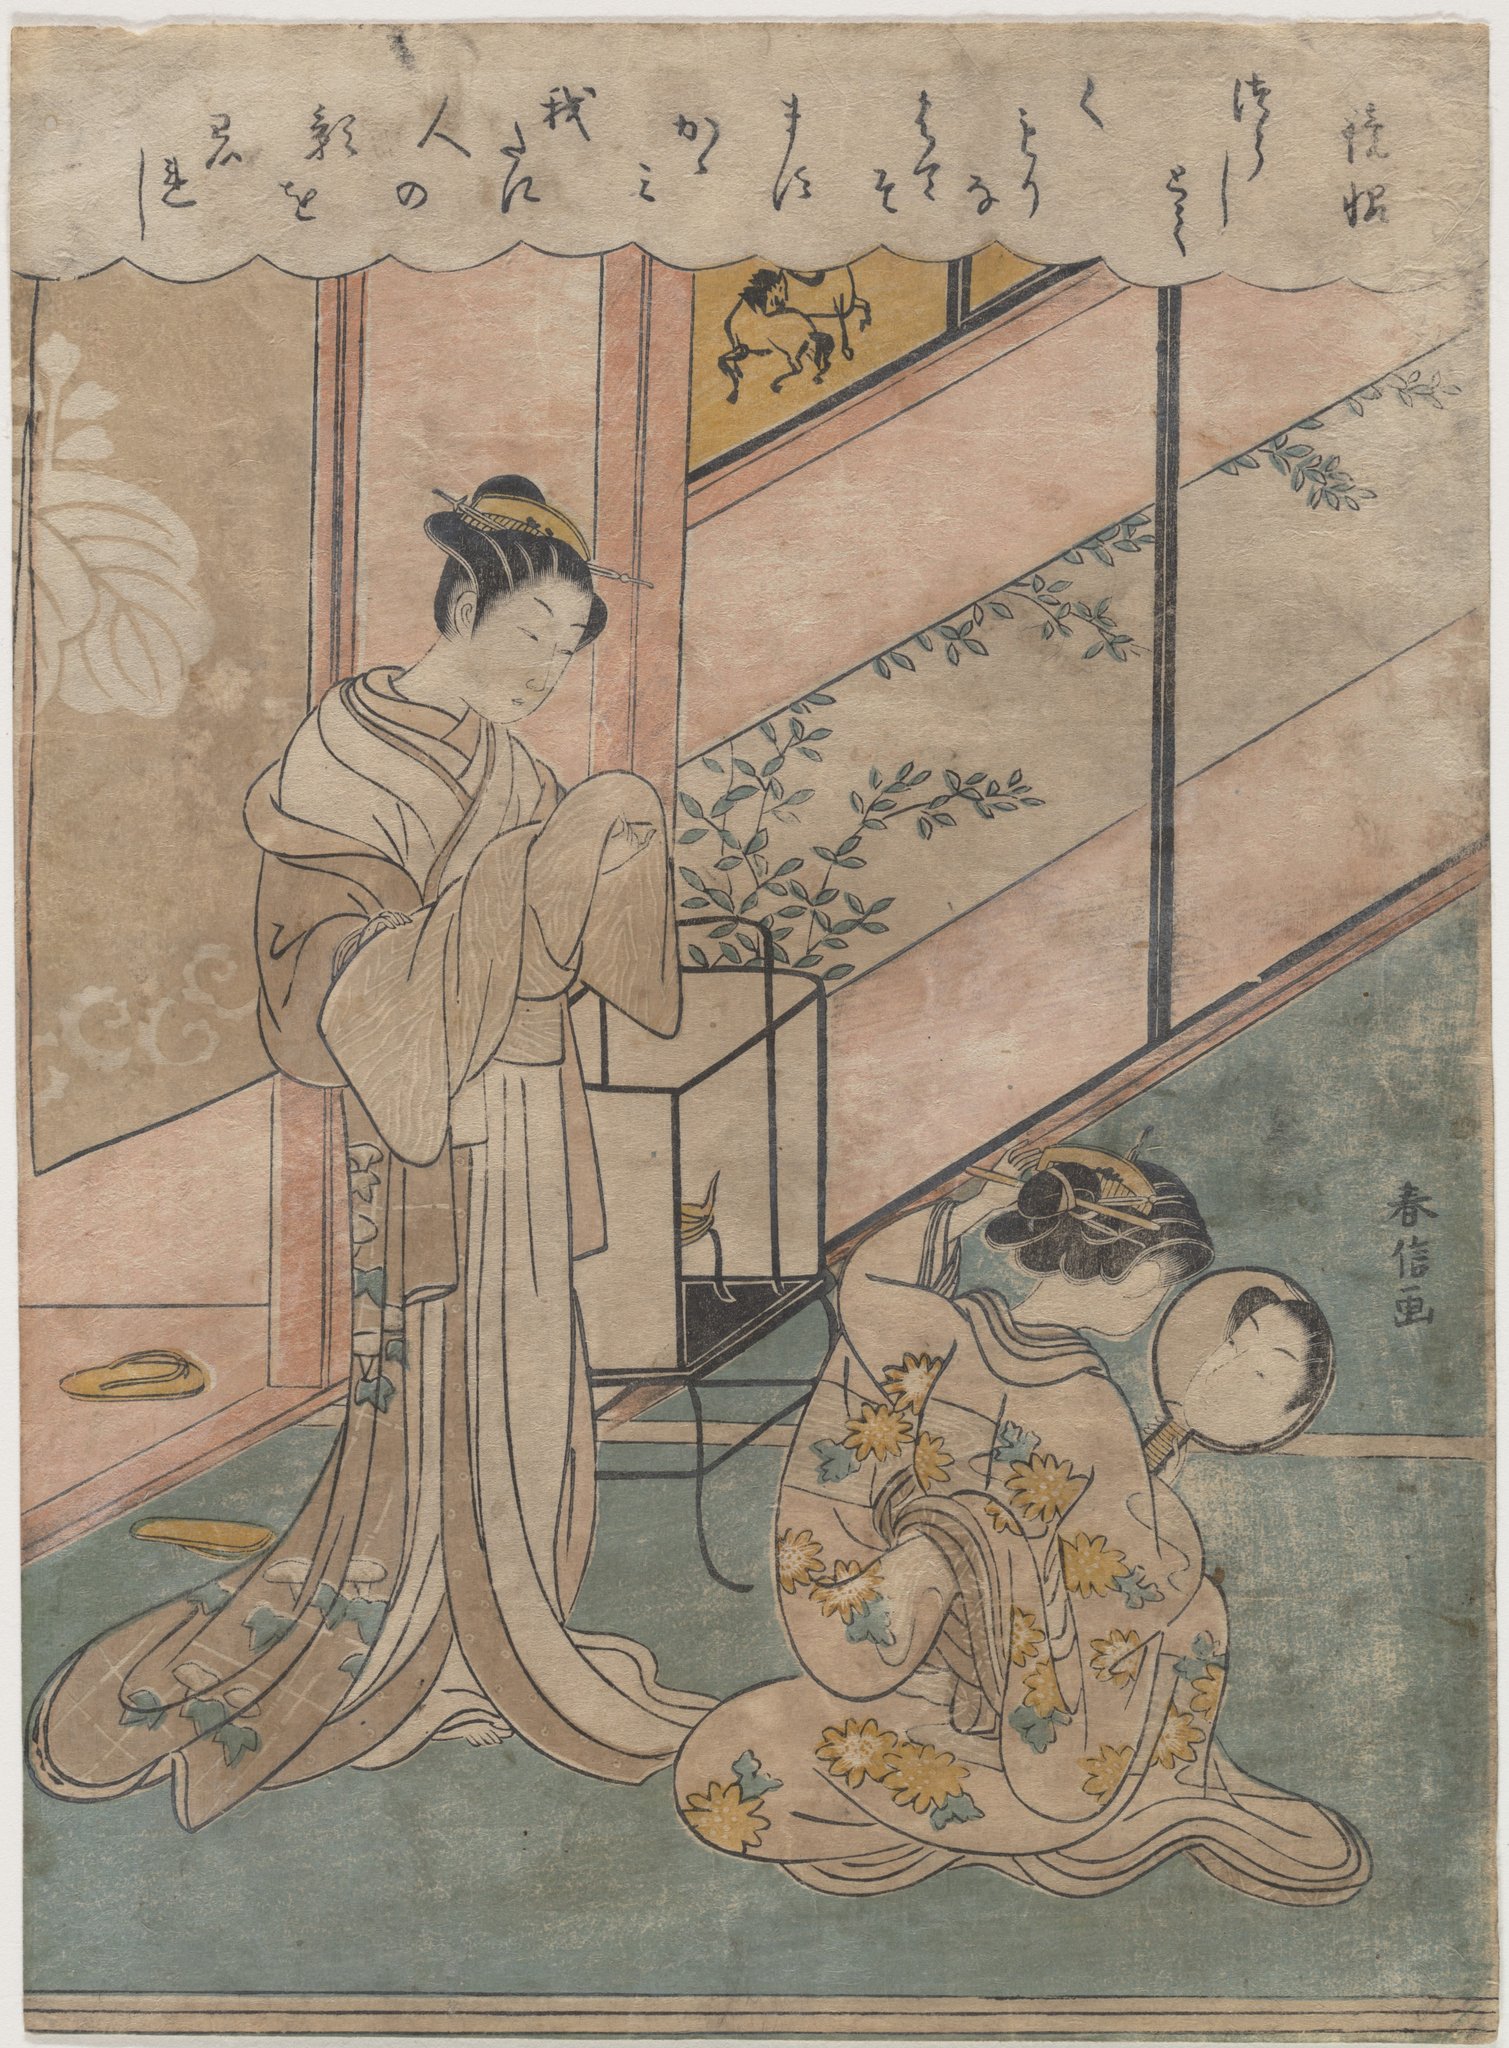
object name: print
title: Two Ladies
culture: japanese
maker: suzuki harunobu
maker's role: artist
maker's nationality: japanese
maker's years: 1725-1770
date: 1764-1772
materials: ink, paper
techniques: woodblock print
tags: poetry,women,mirrors